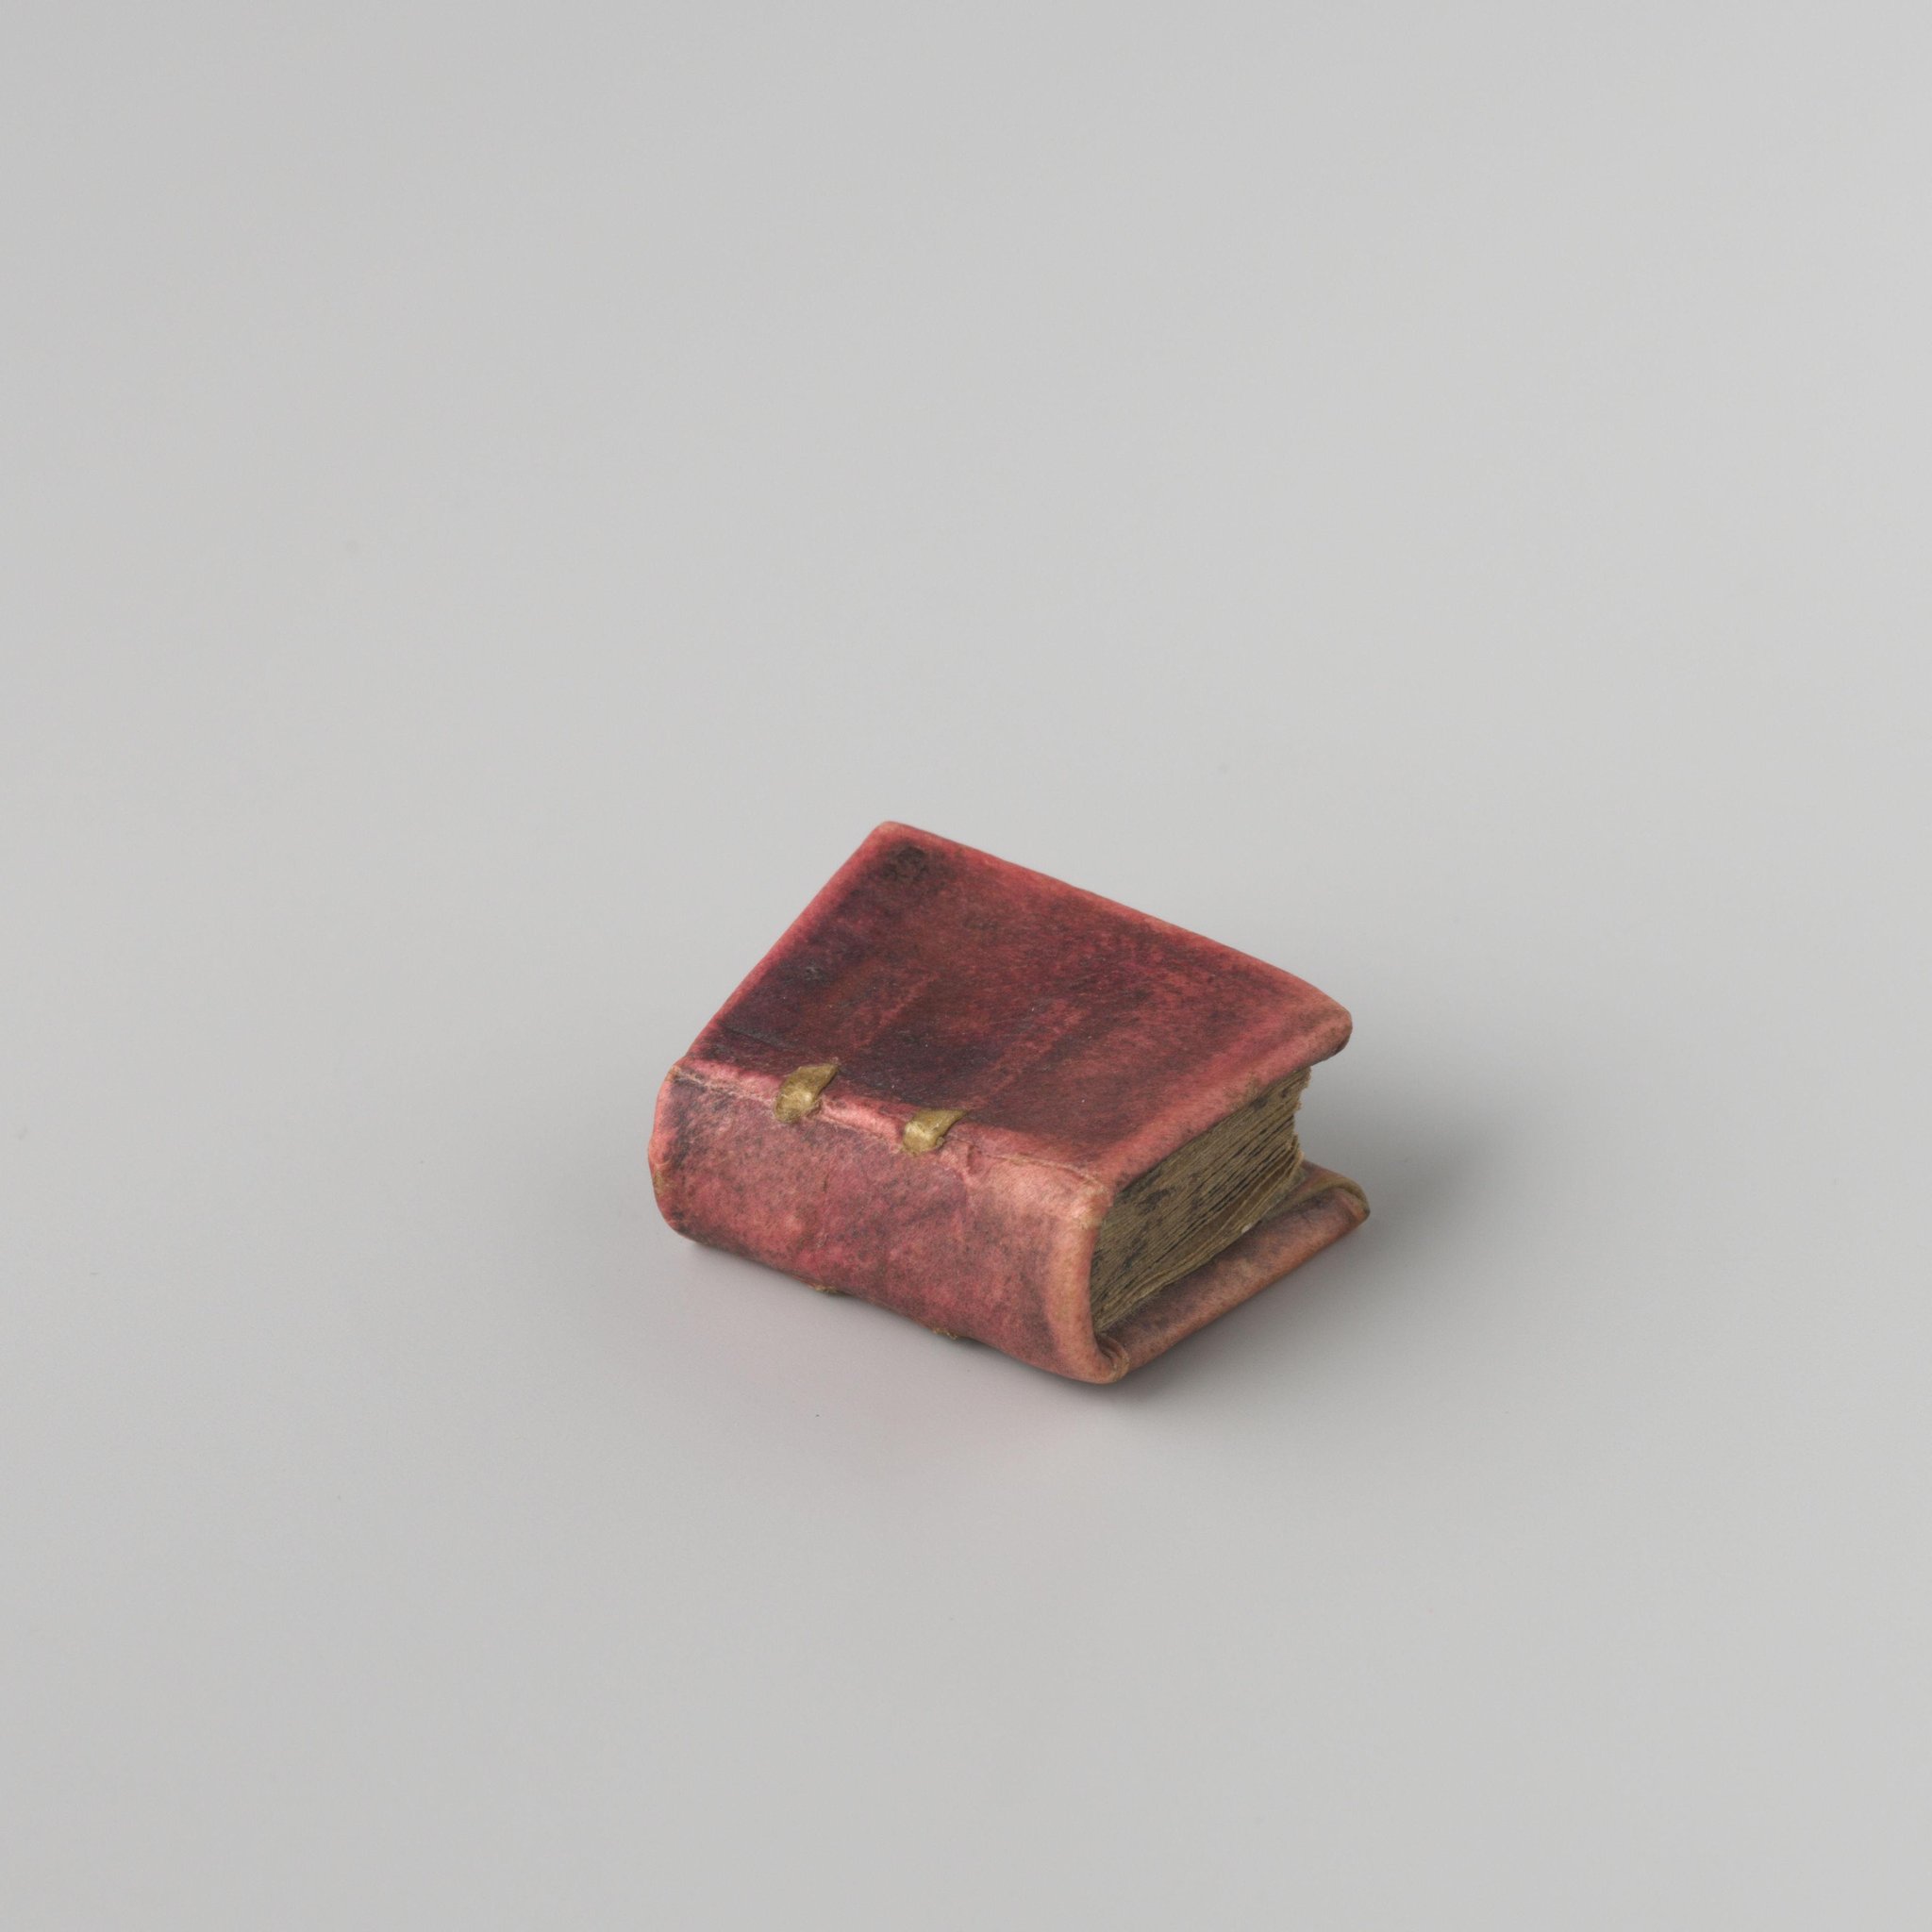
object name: miniature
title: Wapenboek met stadswapens van Hollandse steden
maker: johannes jacobsz van den aveele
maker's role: print maker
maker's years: 1655-1727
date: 1672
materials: paper, parchment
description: Boek, gebonden in roze gekleurd perkament (z.g. splitsel binding), snede groen-bruin gespat; vele katernen van 2 bladen, gevormd door uitgeknipte en deels aan een kim of plakstrook van het vooraf aan de blad aangehechte, ingekleurde stadswapens: Hollandsche Steden (23 stuks).